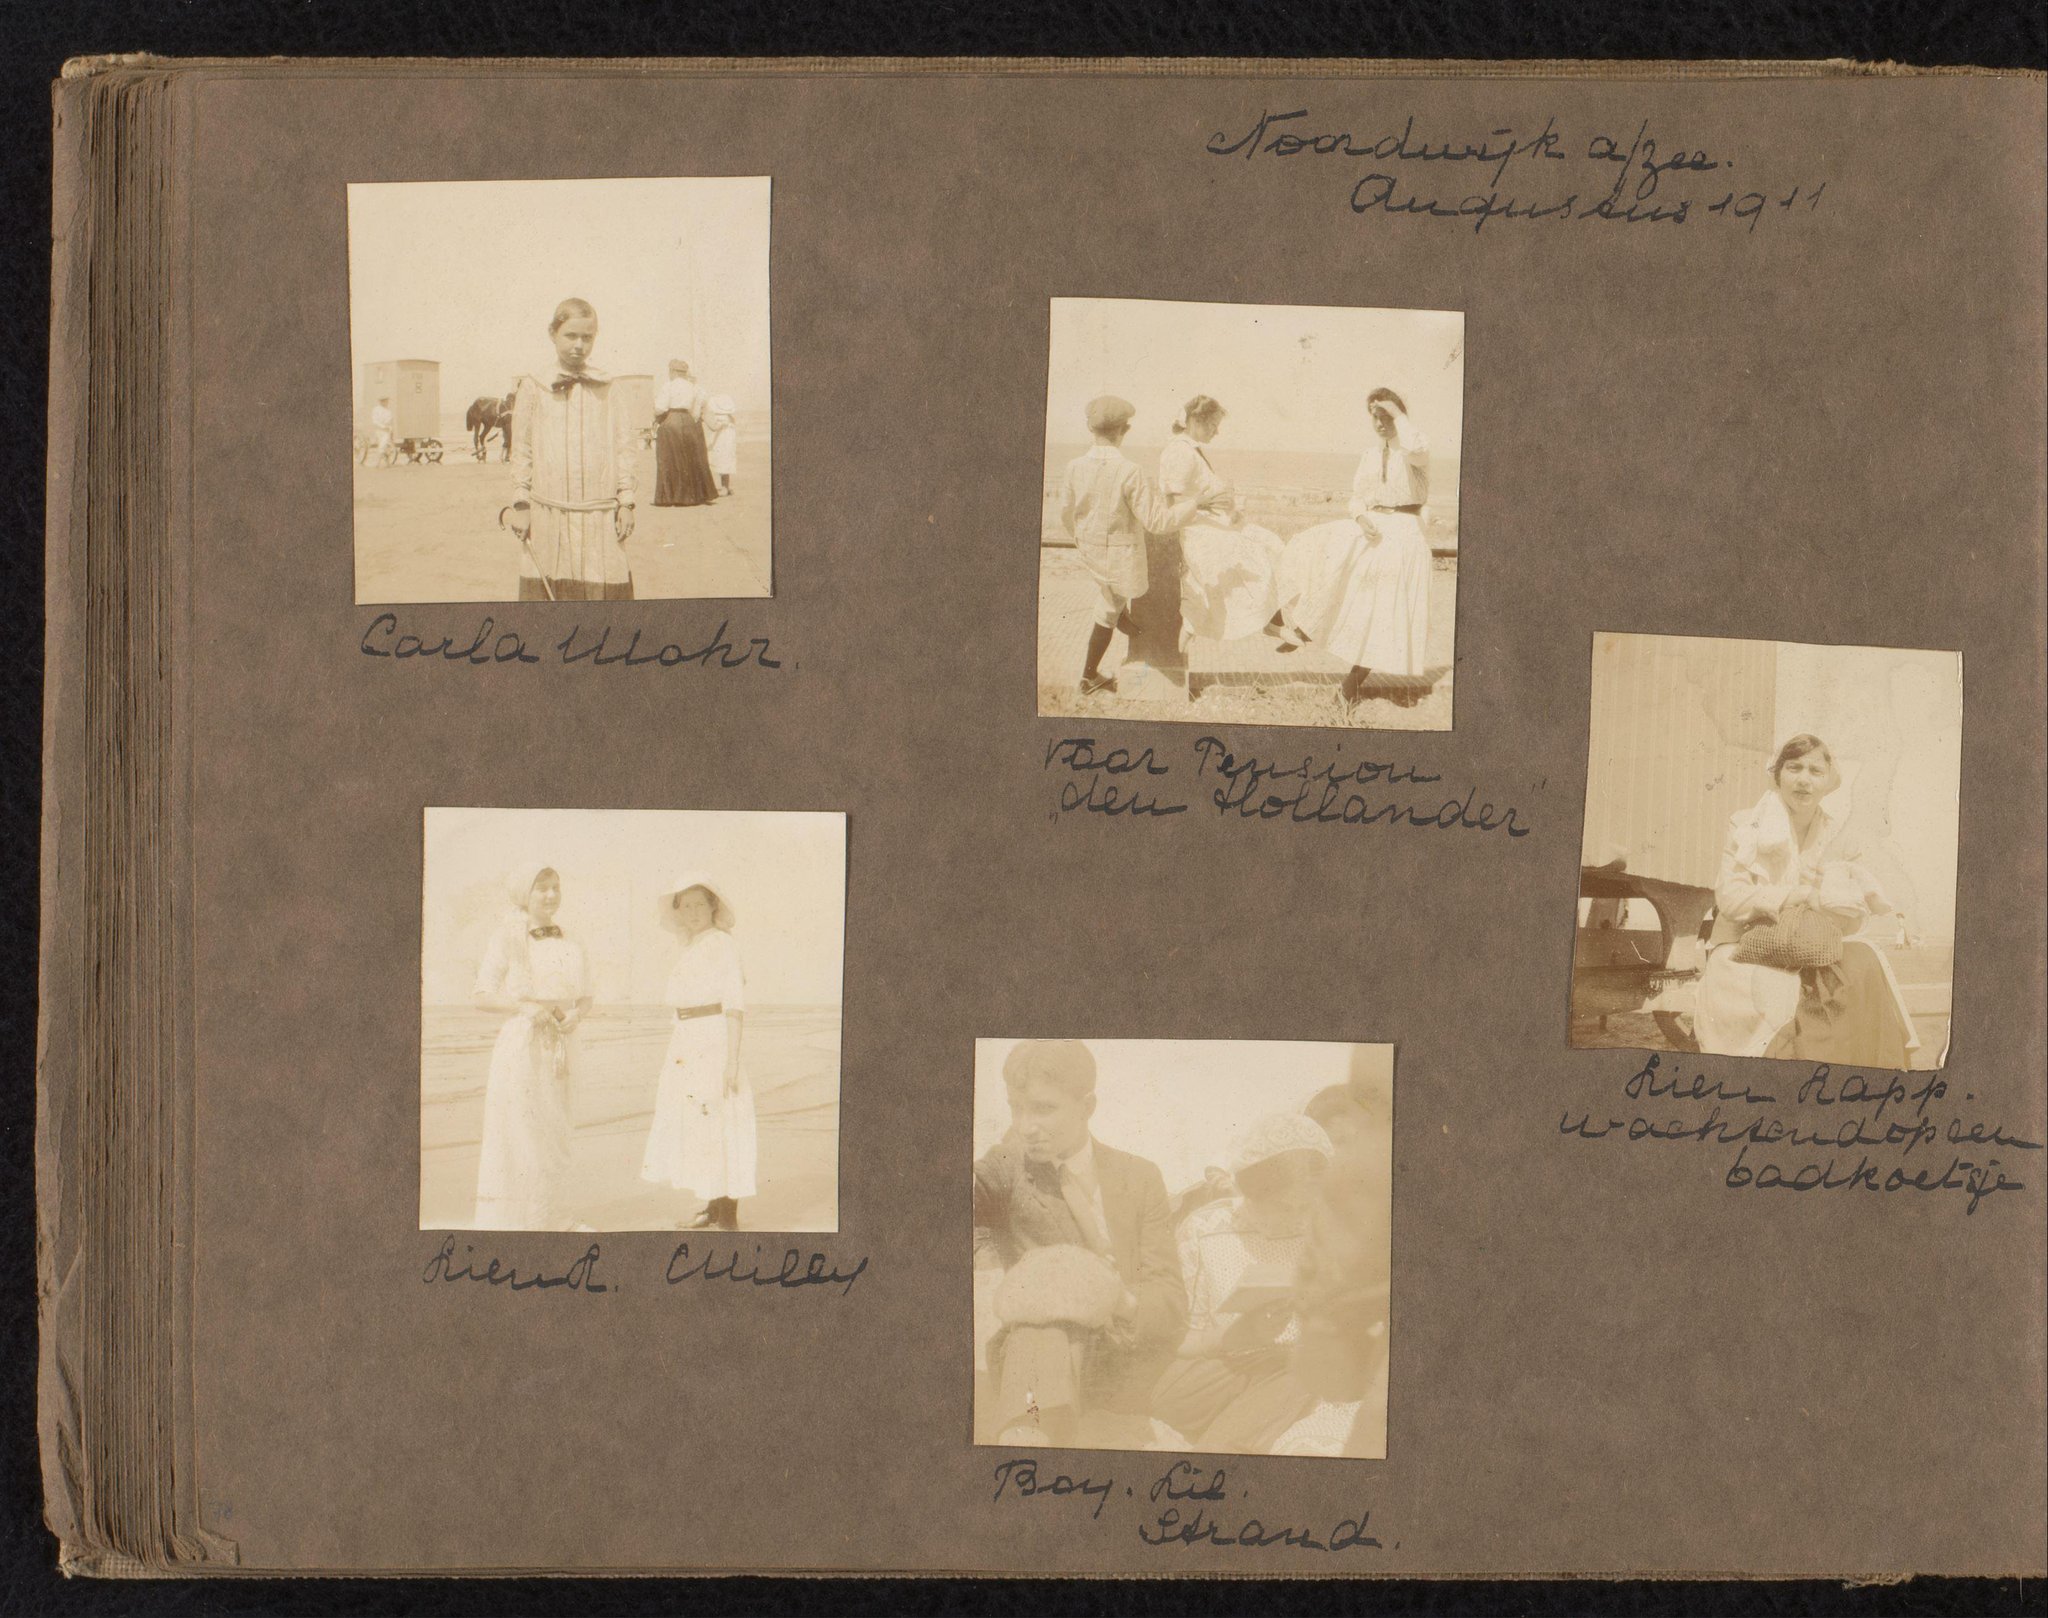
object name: photograph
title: Vijf foto's van een vakantie in Noordwijk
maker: carolina frederika onnen (lien/loen)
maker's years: 1896-1983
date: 1908-1911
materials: paper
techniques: gelatin silver print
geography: noordwijk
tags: batavia, beach (as place of recreation), historical persons - bb - woman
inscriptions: inscription: ‘Voor Pension/ "den Hollander"’, inscription: ‘Lien Lapp/ wachtend op een/ badkoetsje’, inscription: ‘Boy. Lil./ Strand.’, inscription: ‘Carla Mohr’, inscription: ‘Lien L. Mily’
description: Deze foto's maken deel uit van een album.